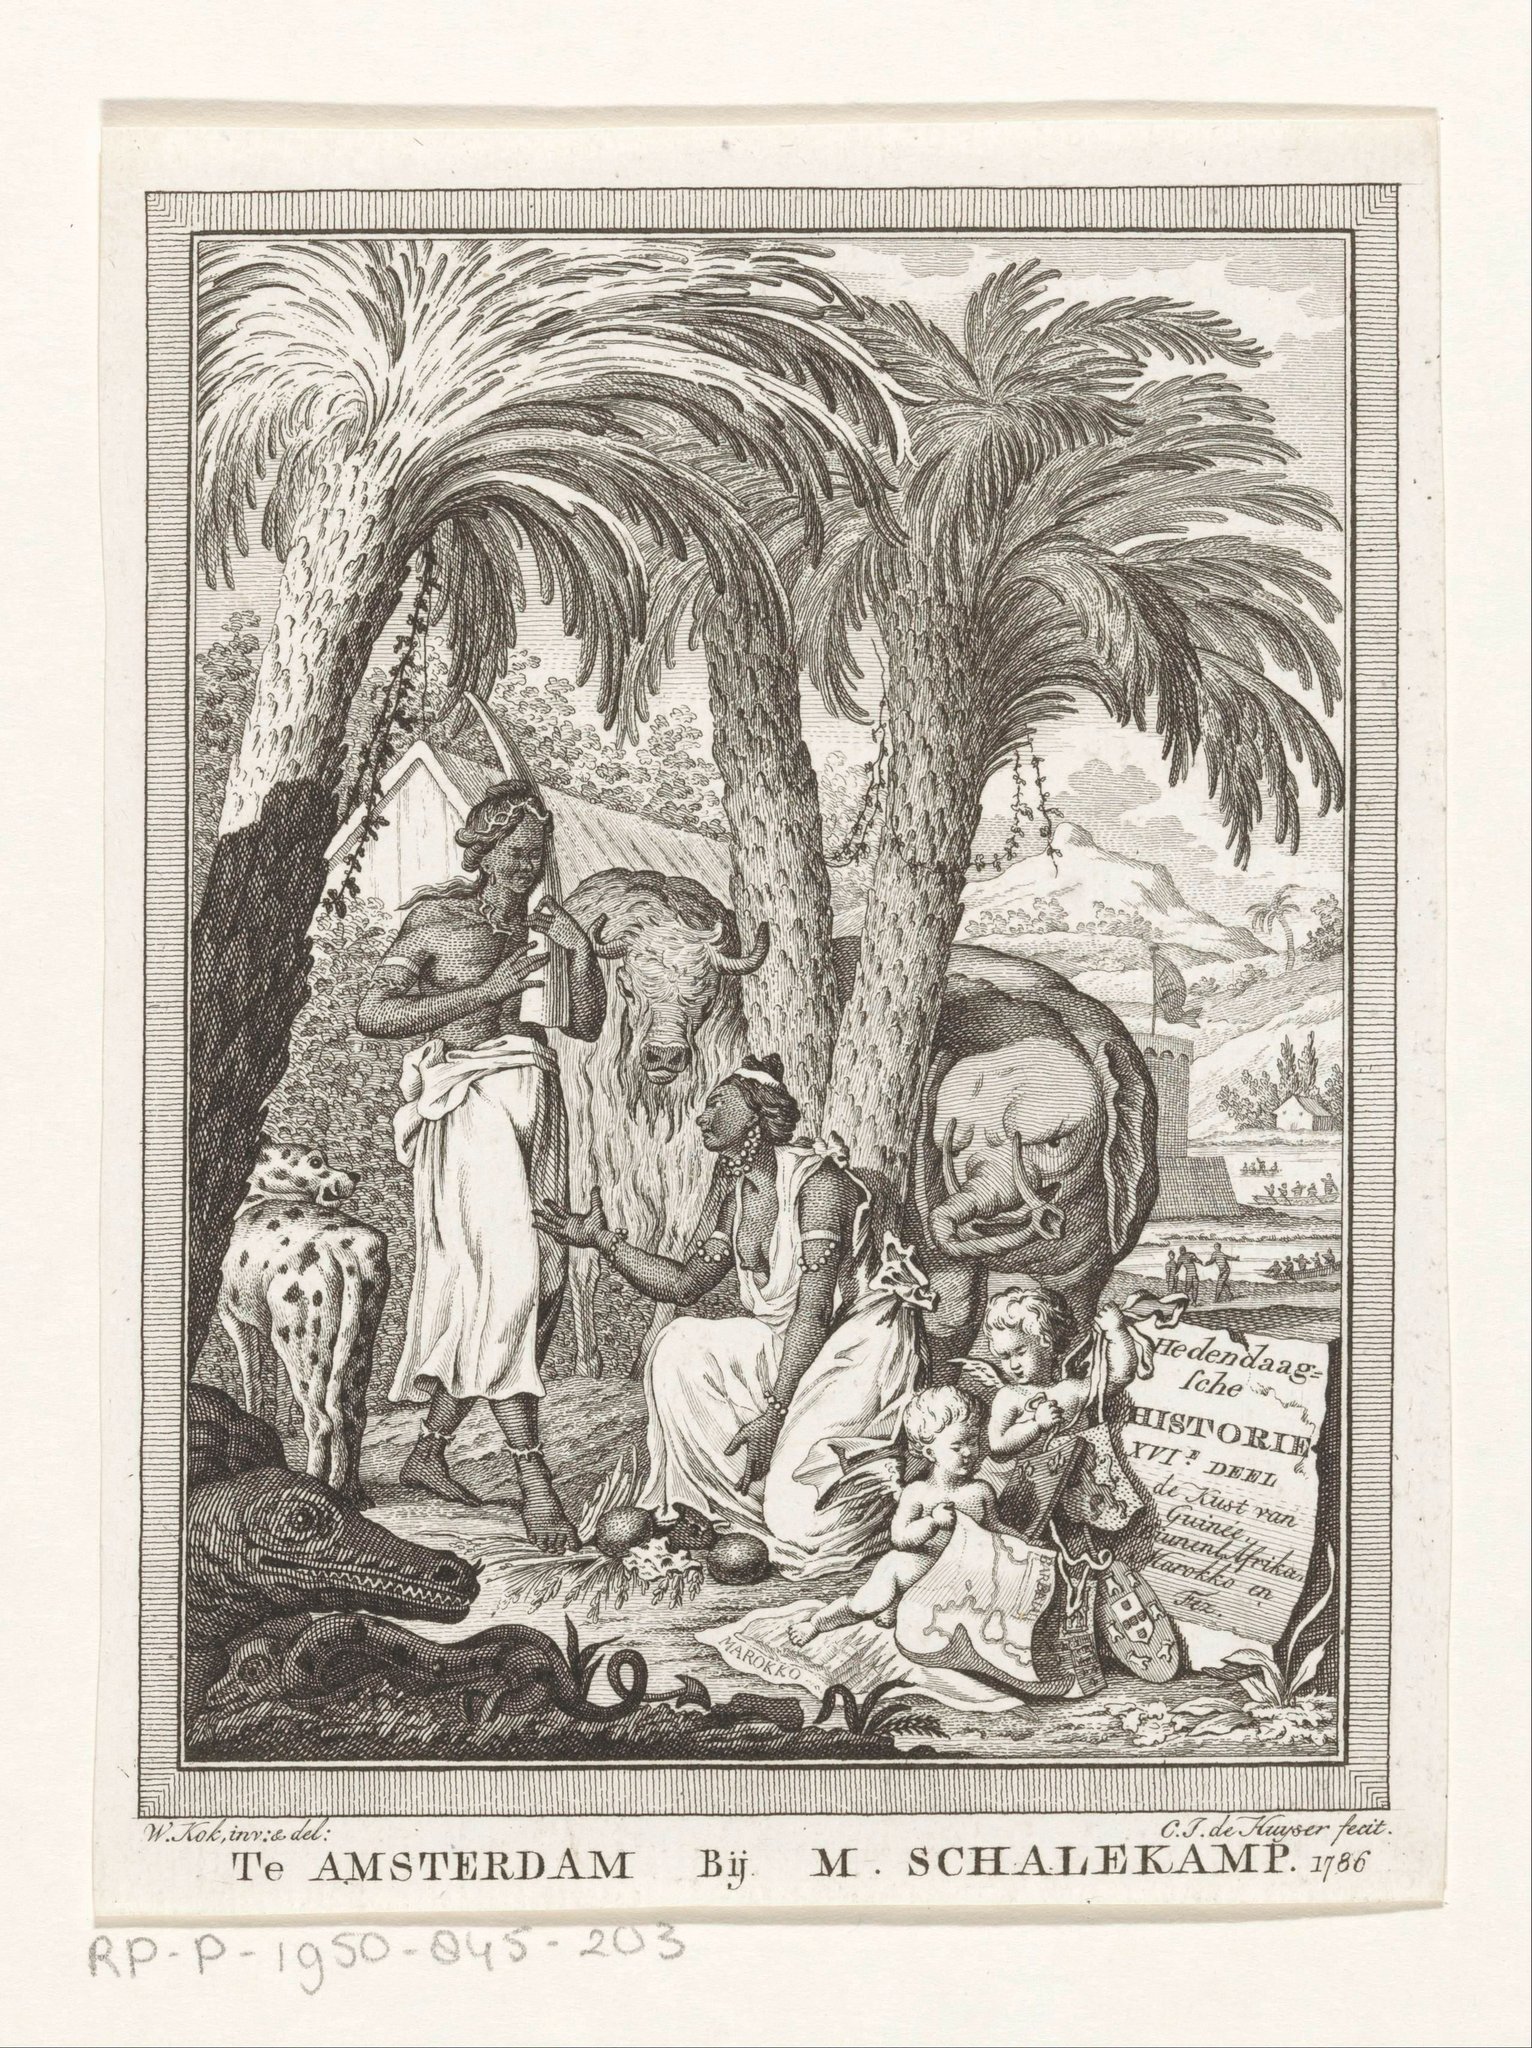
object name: print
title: Titelpagina voor: S.n., Hedendaagsche historie of Het vervolg van de Algemeene historie, 1786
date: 1786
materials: paper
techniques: engraving, etching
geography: amsterdam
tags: africa represented allegorically; 'africa' (ripa)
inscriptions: collector's mark: Lugt 2228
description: Titelpagina voor: S.n. Hedendaagsche historie of Het vervolg van de Algemeene historie (...) XIVde deel. Amsterdam: Schalekamp, M., 1786. Prent afkomstig uit een plakalbum met titelprenten, ornamenten etc. op blauw papier in 1983 uit elkaar gehaald. Volgens een notitie op verso zat de prent op p. 203 van dit album.